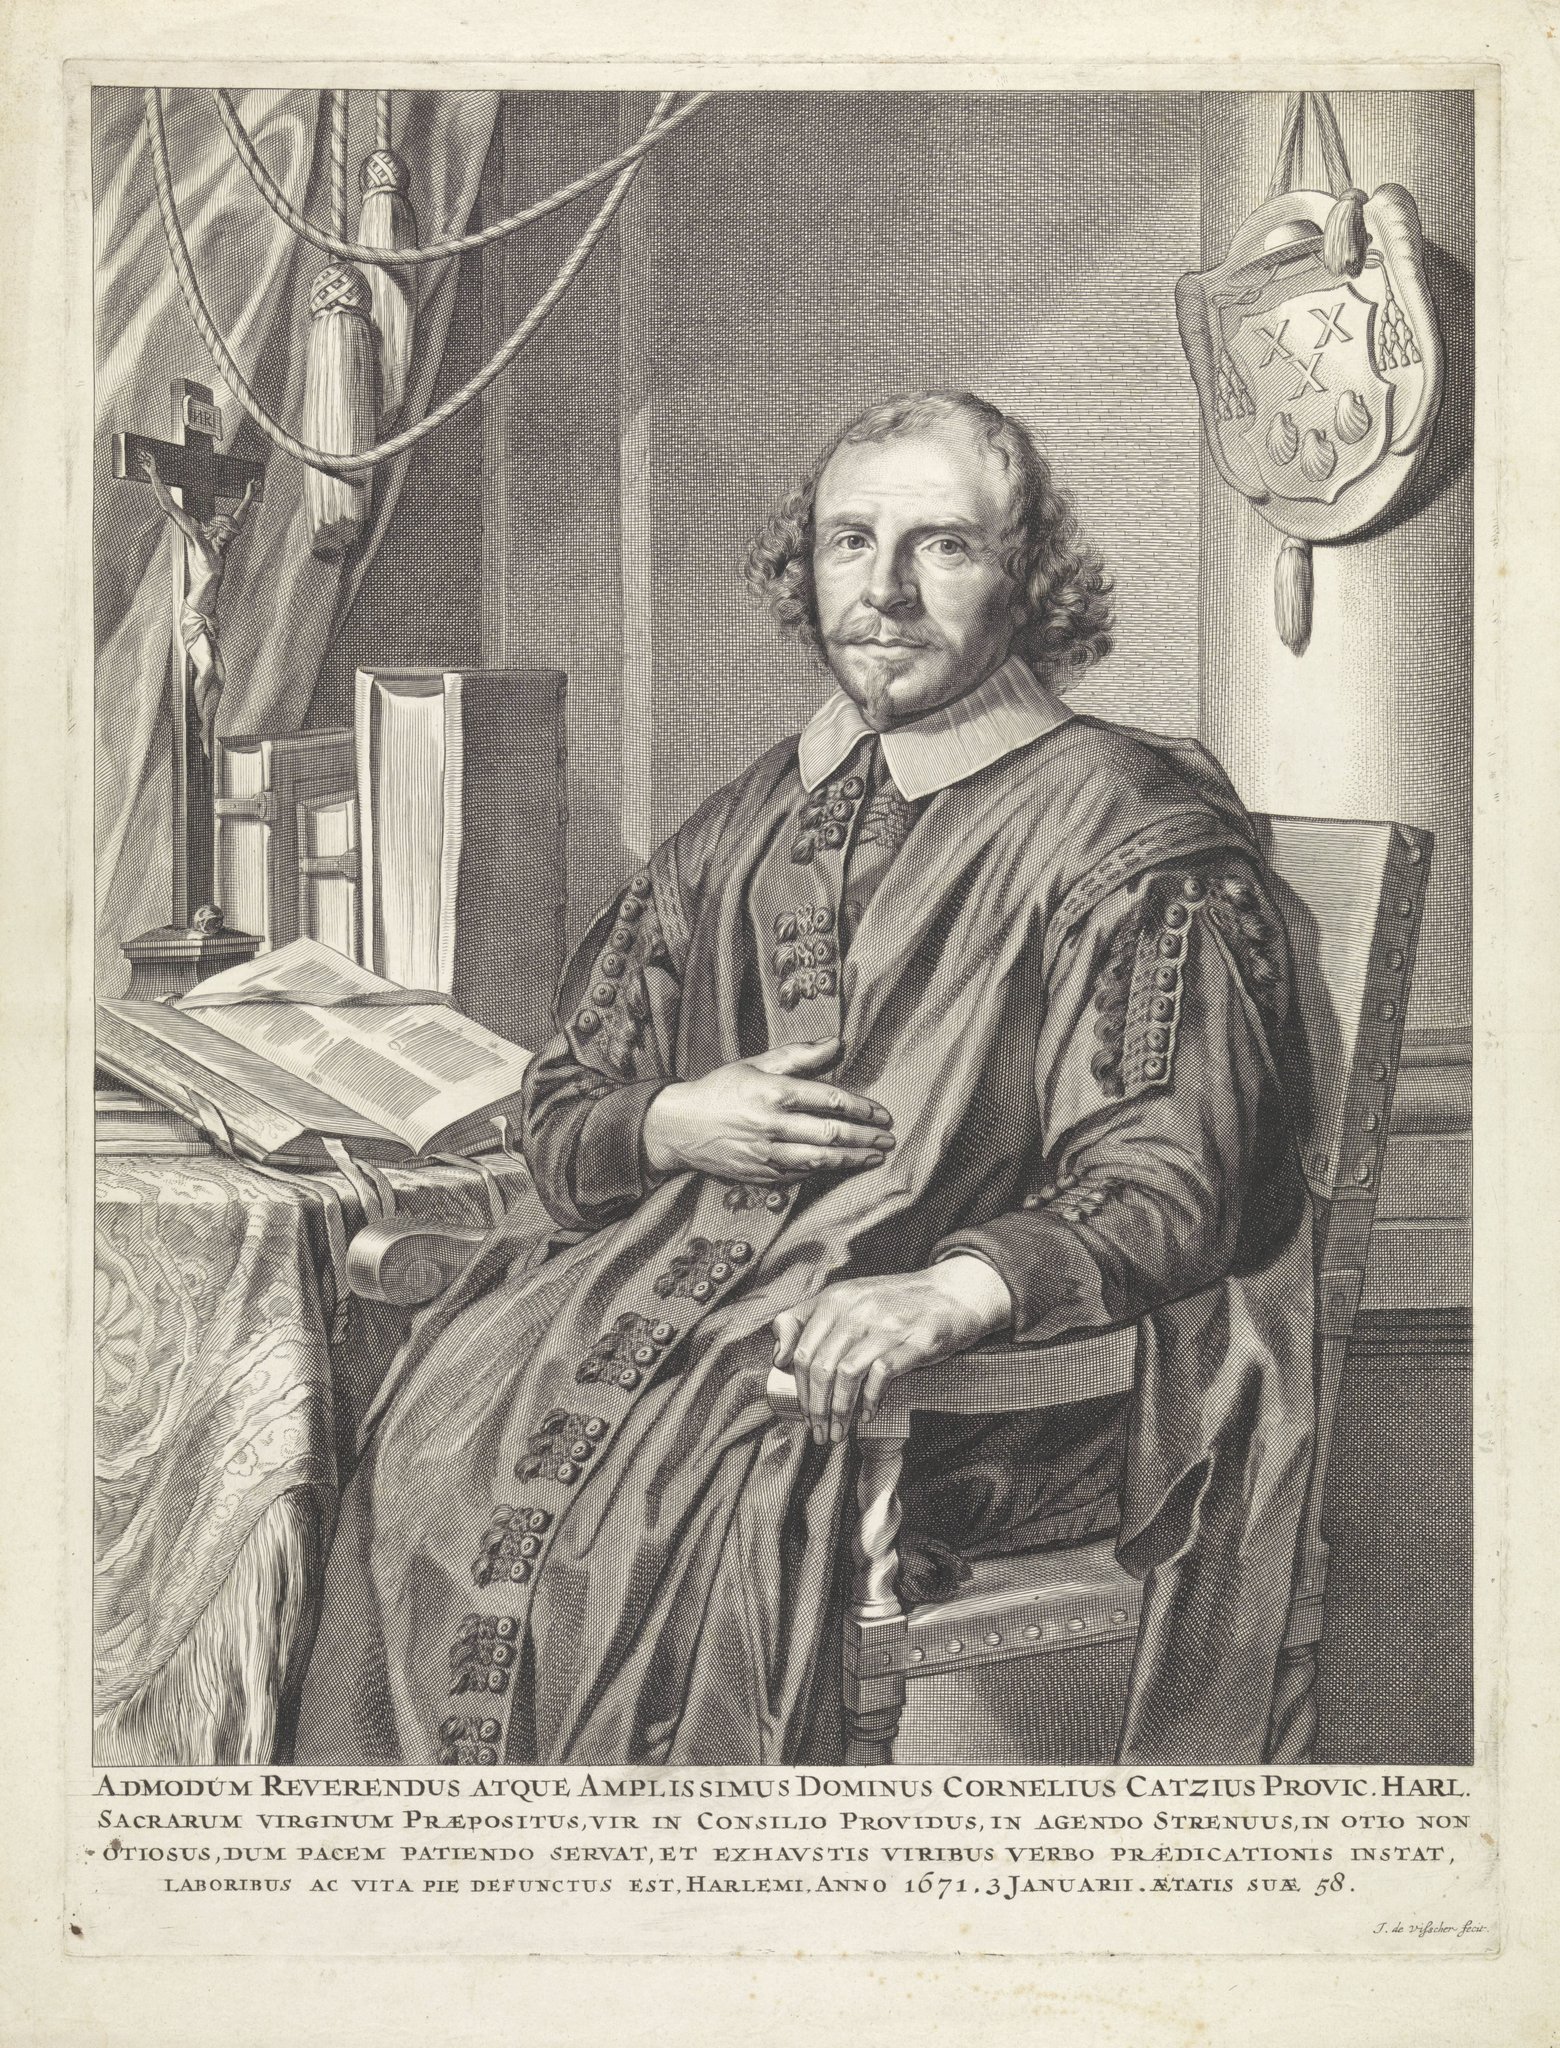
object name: print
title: Portret van Cornelis Cats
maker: jan de visscher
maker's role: print maker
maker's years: 1633-1712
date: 1671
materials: paper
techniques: engraving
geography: northern netherlands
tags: book, crucifix ~ personal devotion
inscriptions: collector's mark: Lugt 240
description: De geestelijke Cornelis Cats, zittend in een stoel aan een tafel met boeken en een crucifix.